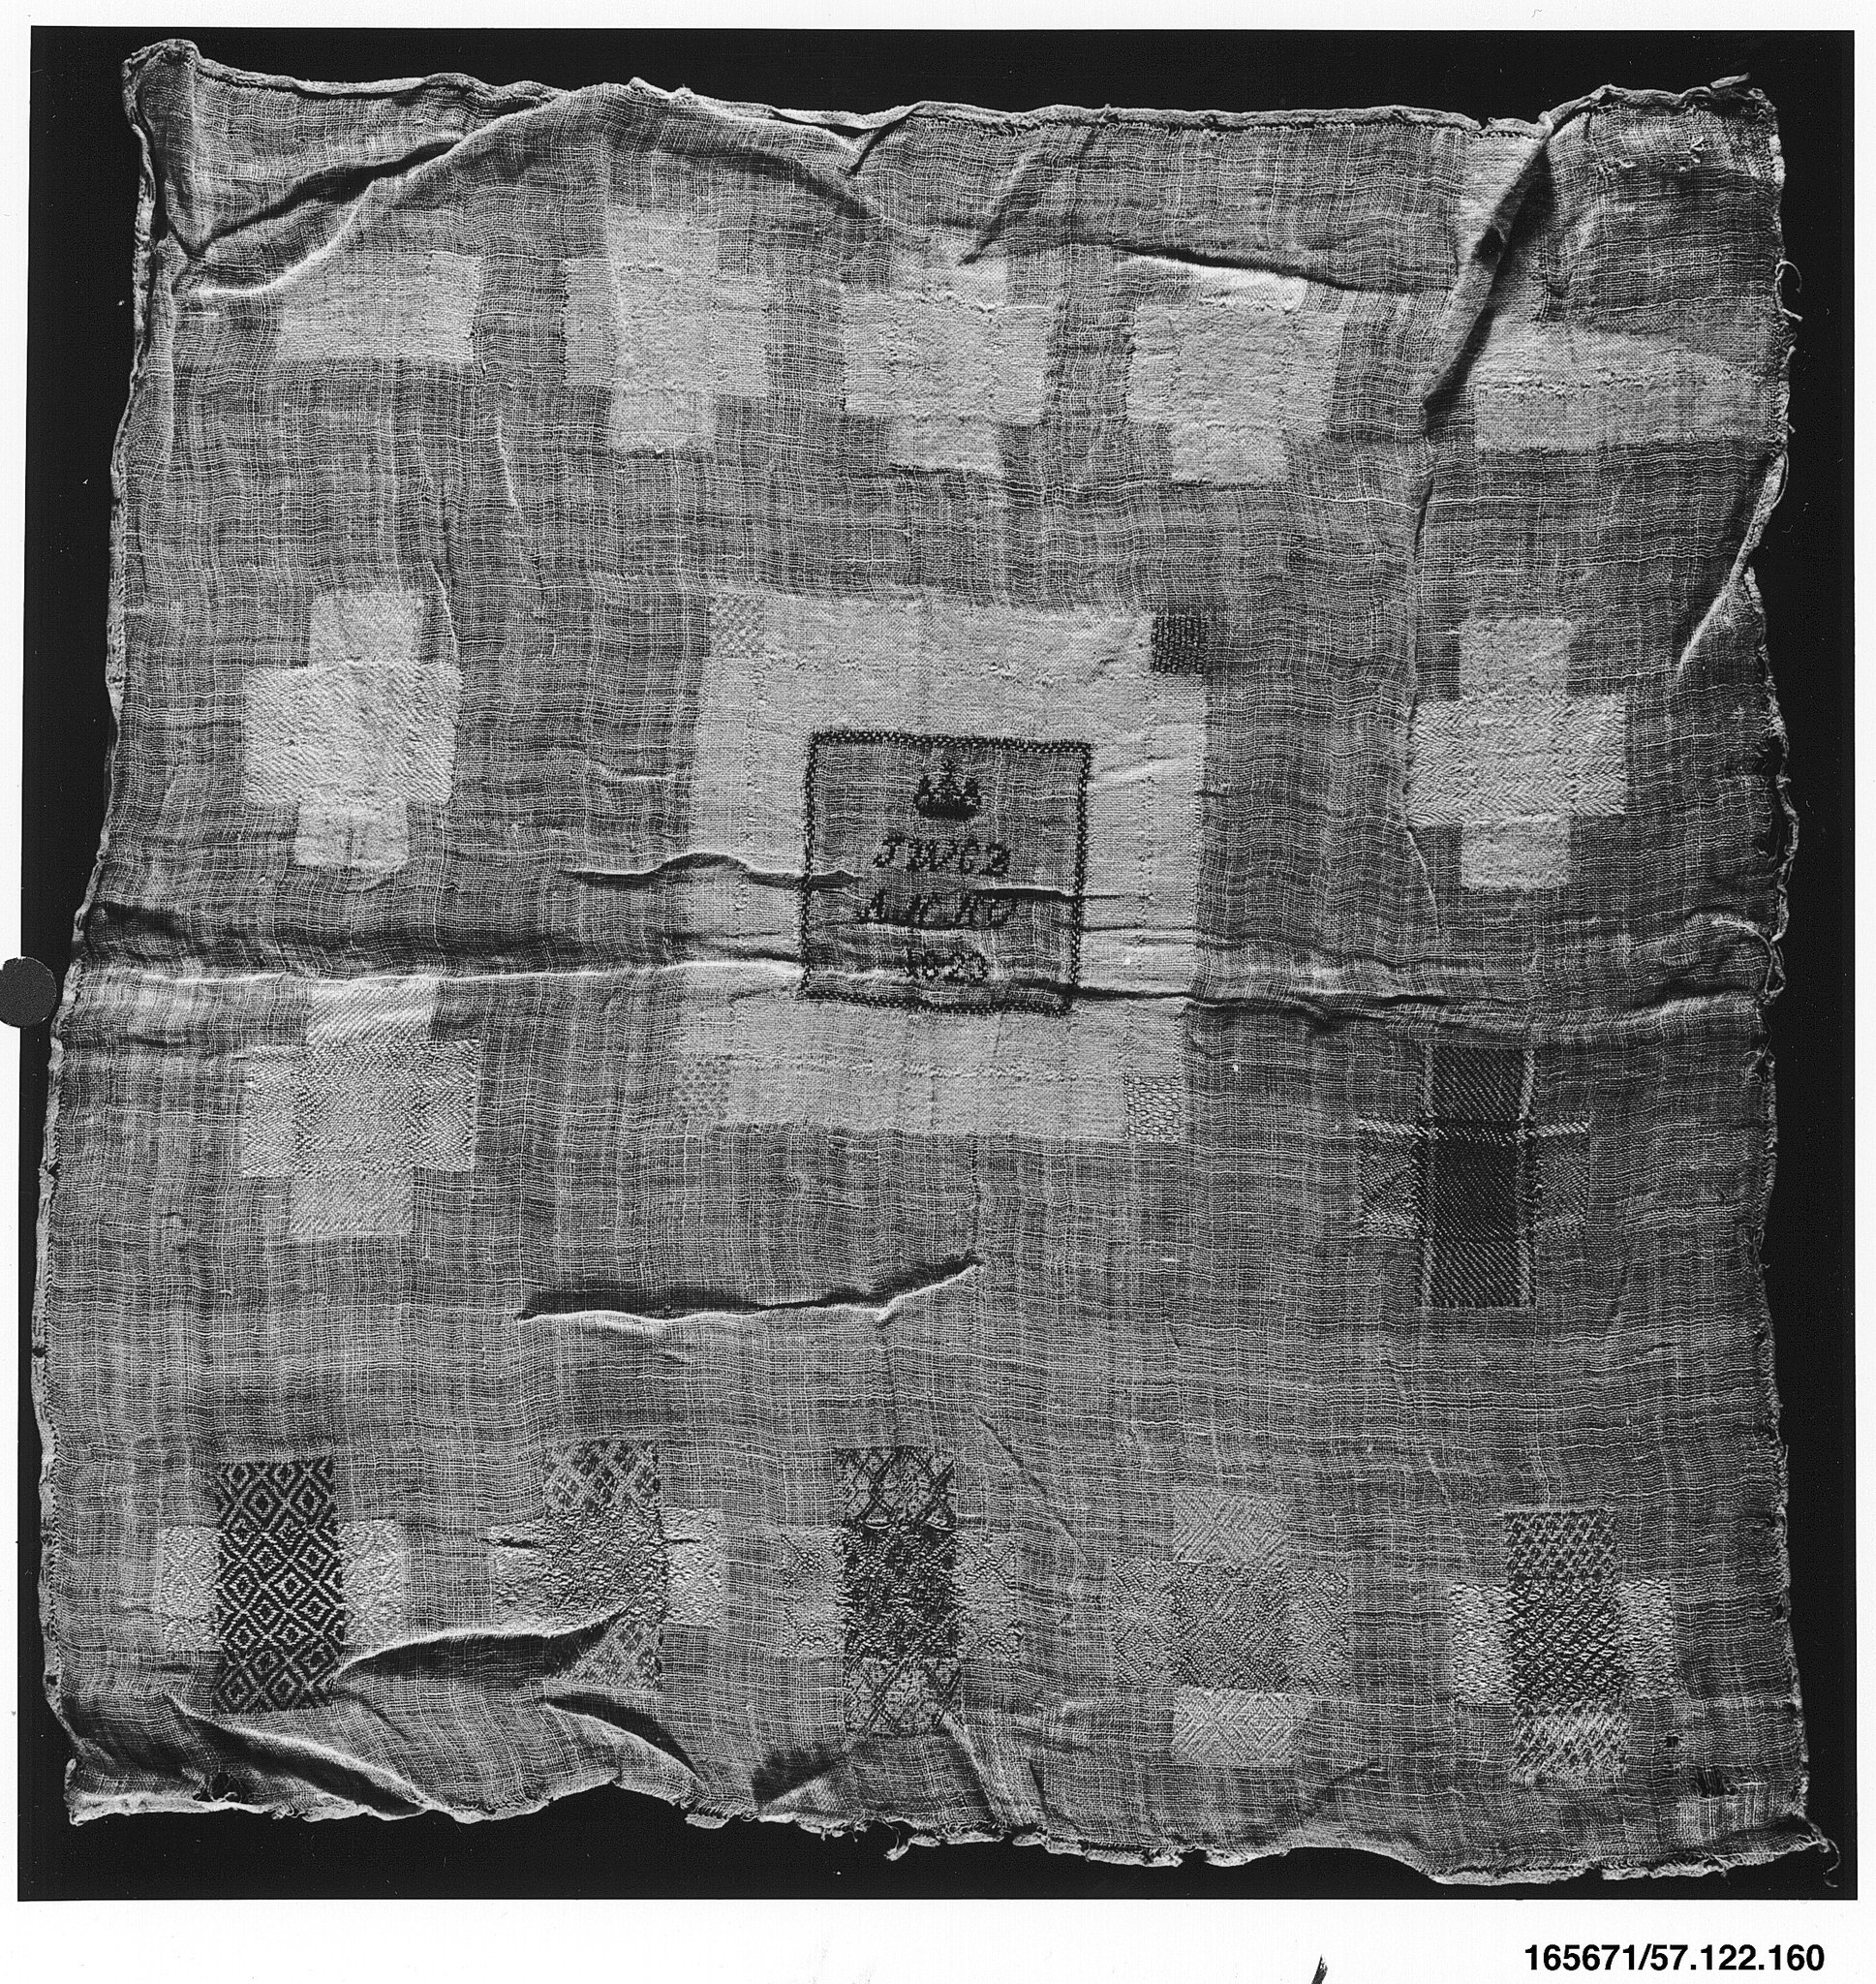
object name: sampler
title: Embroidered darning sampler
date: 1823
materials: linen, silk